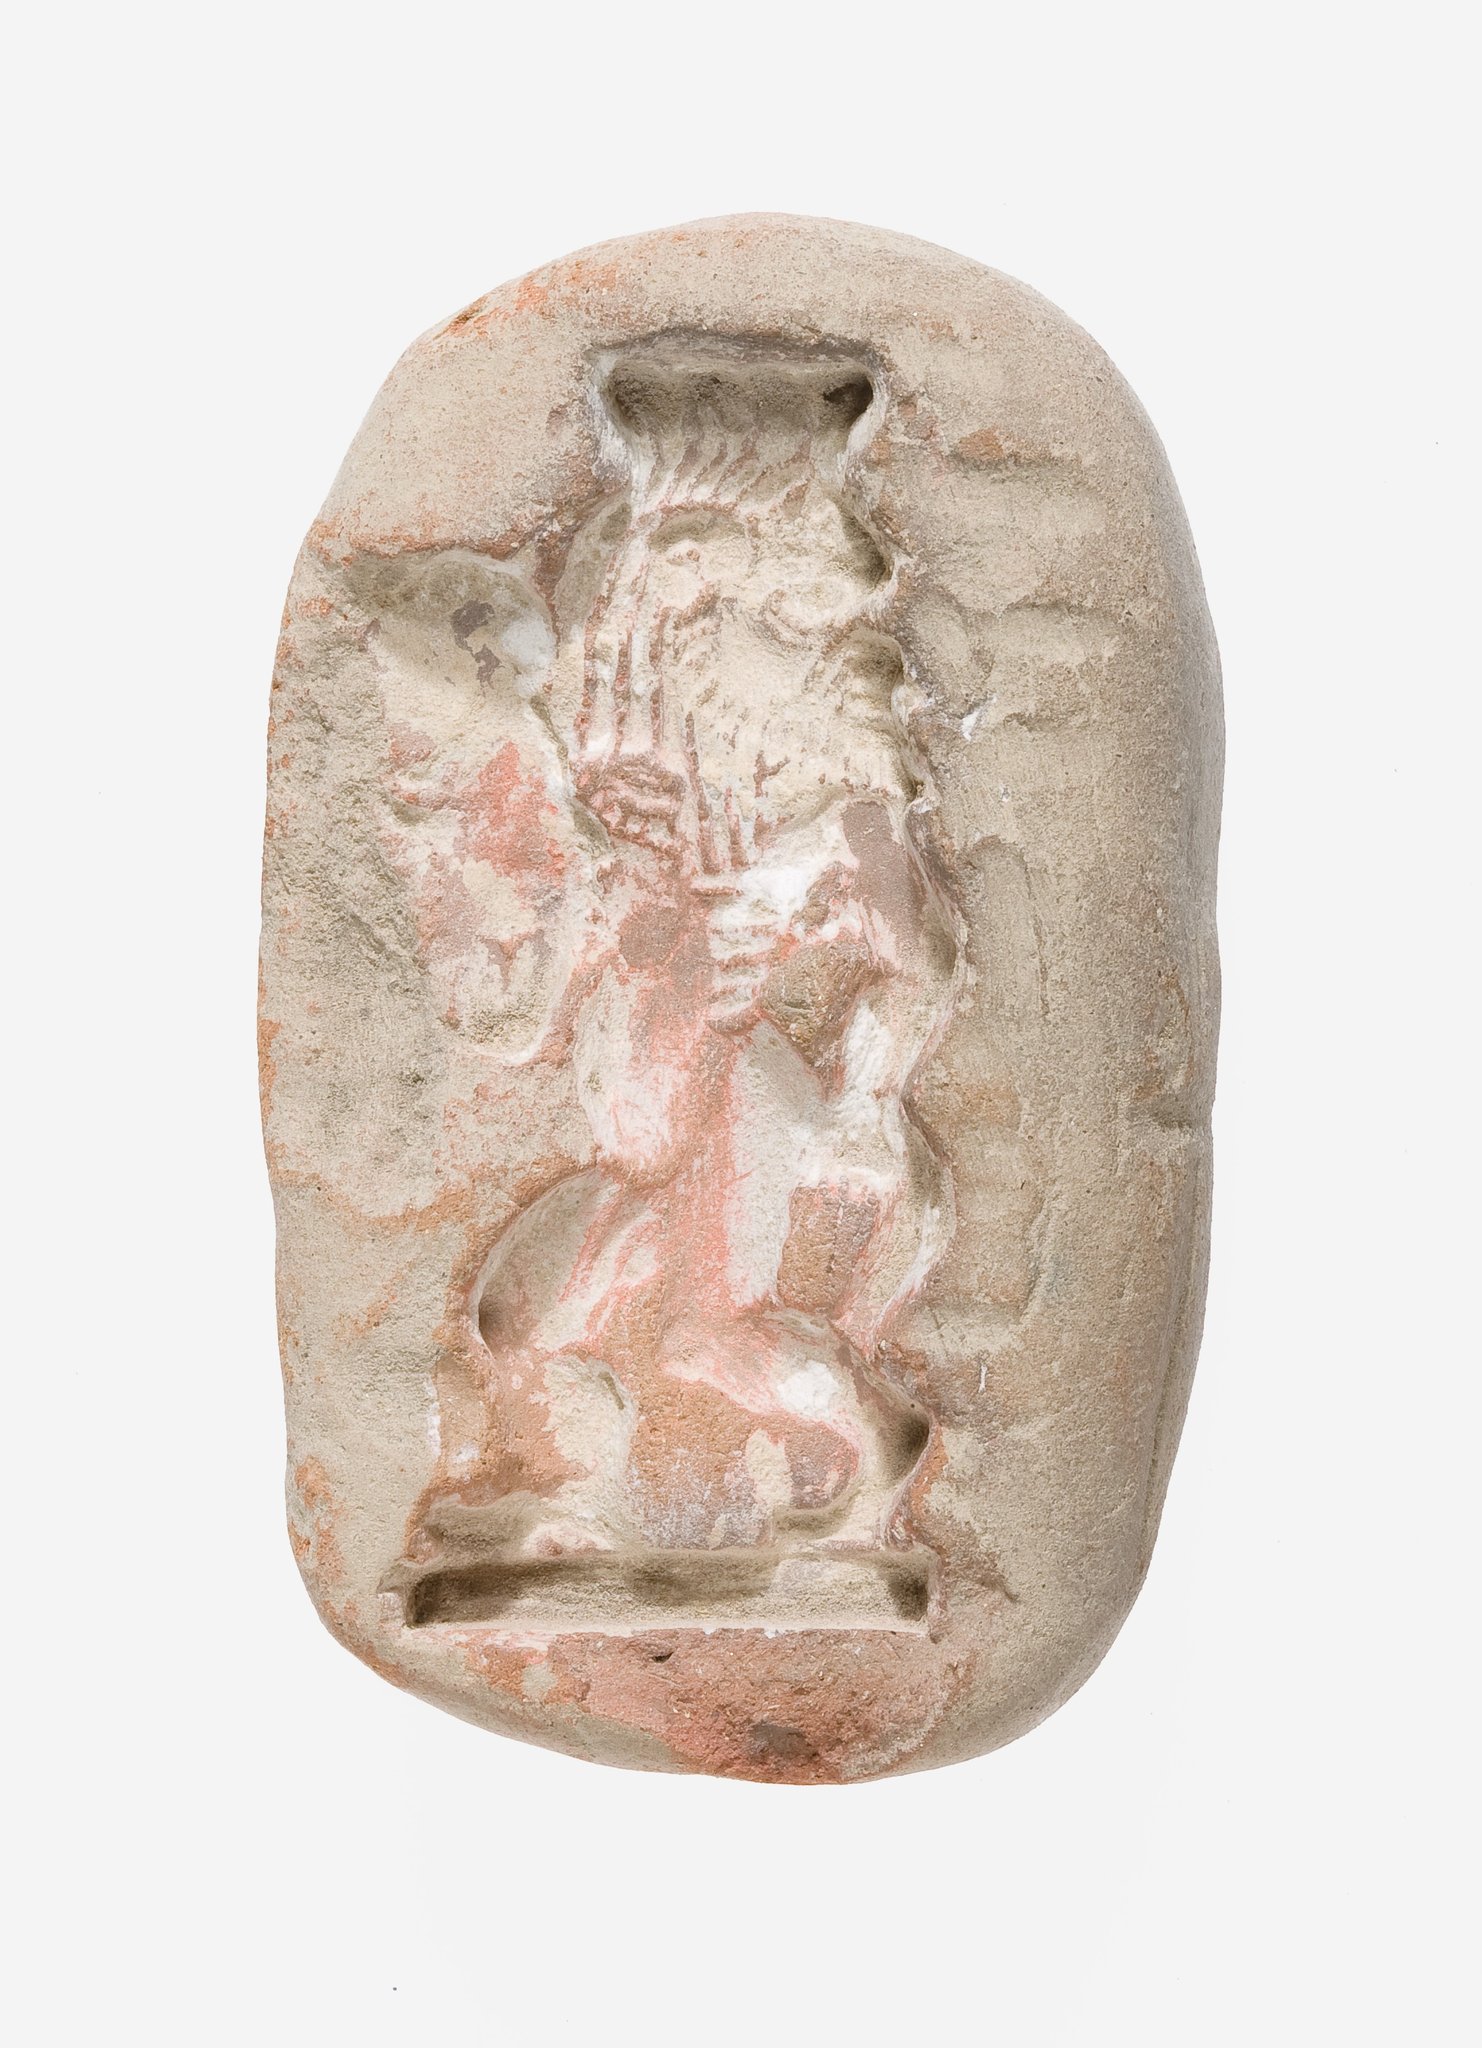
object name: mold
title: Mold: Bes with Tambourine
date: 1390-1352 BCE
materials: pottery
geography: egypt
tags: bes